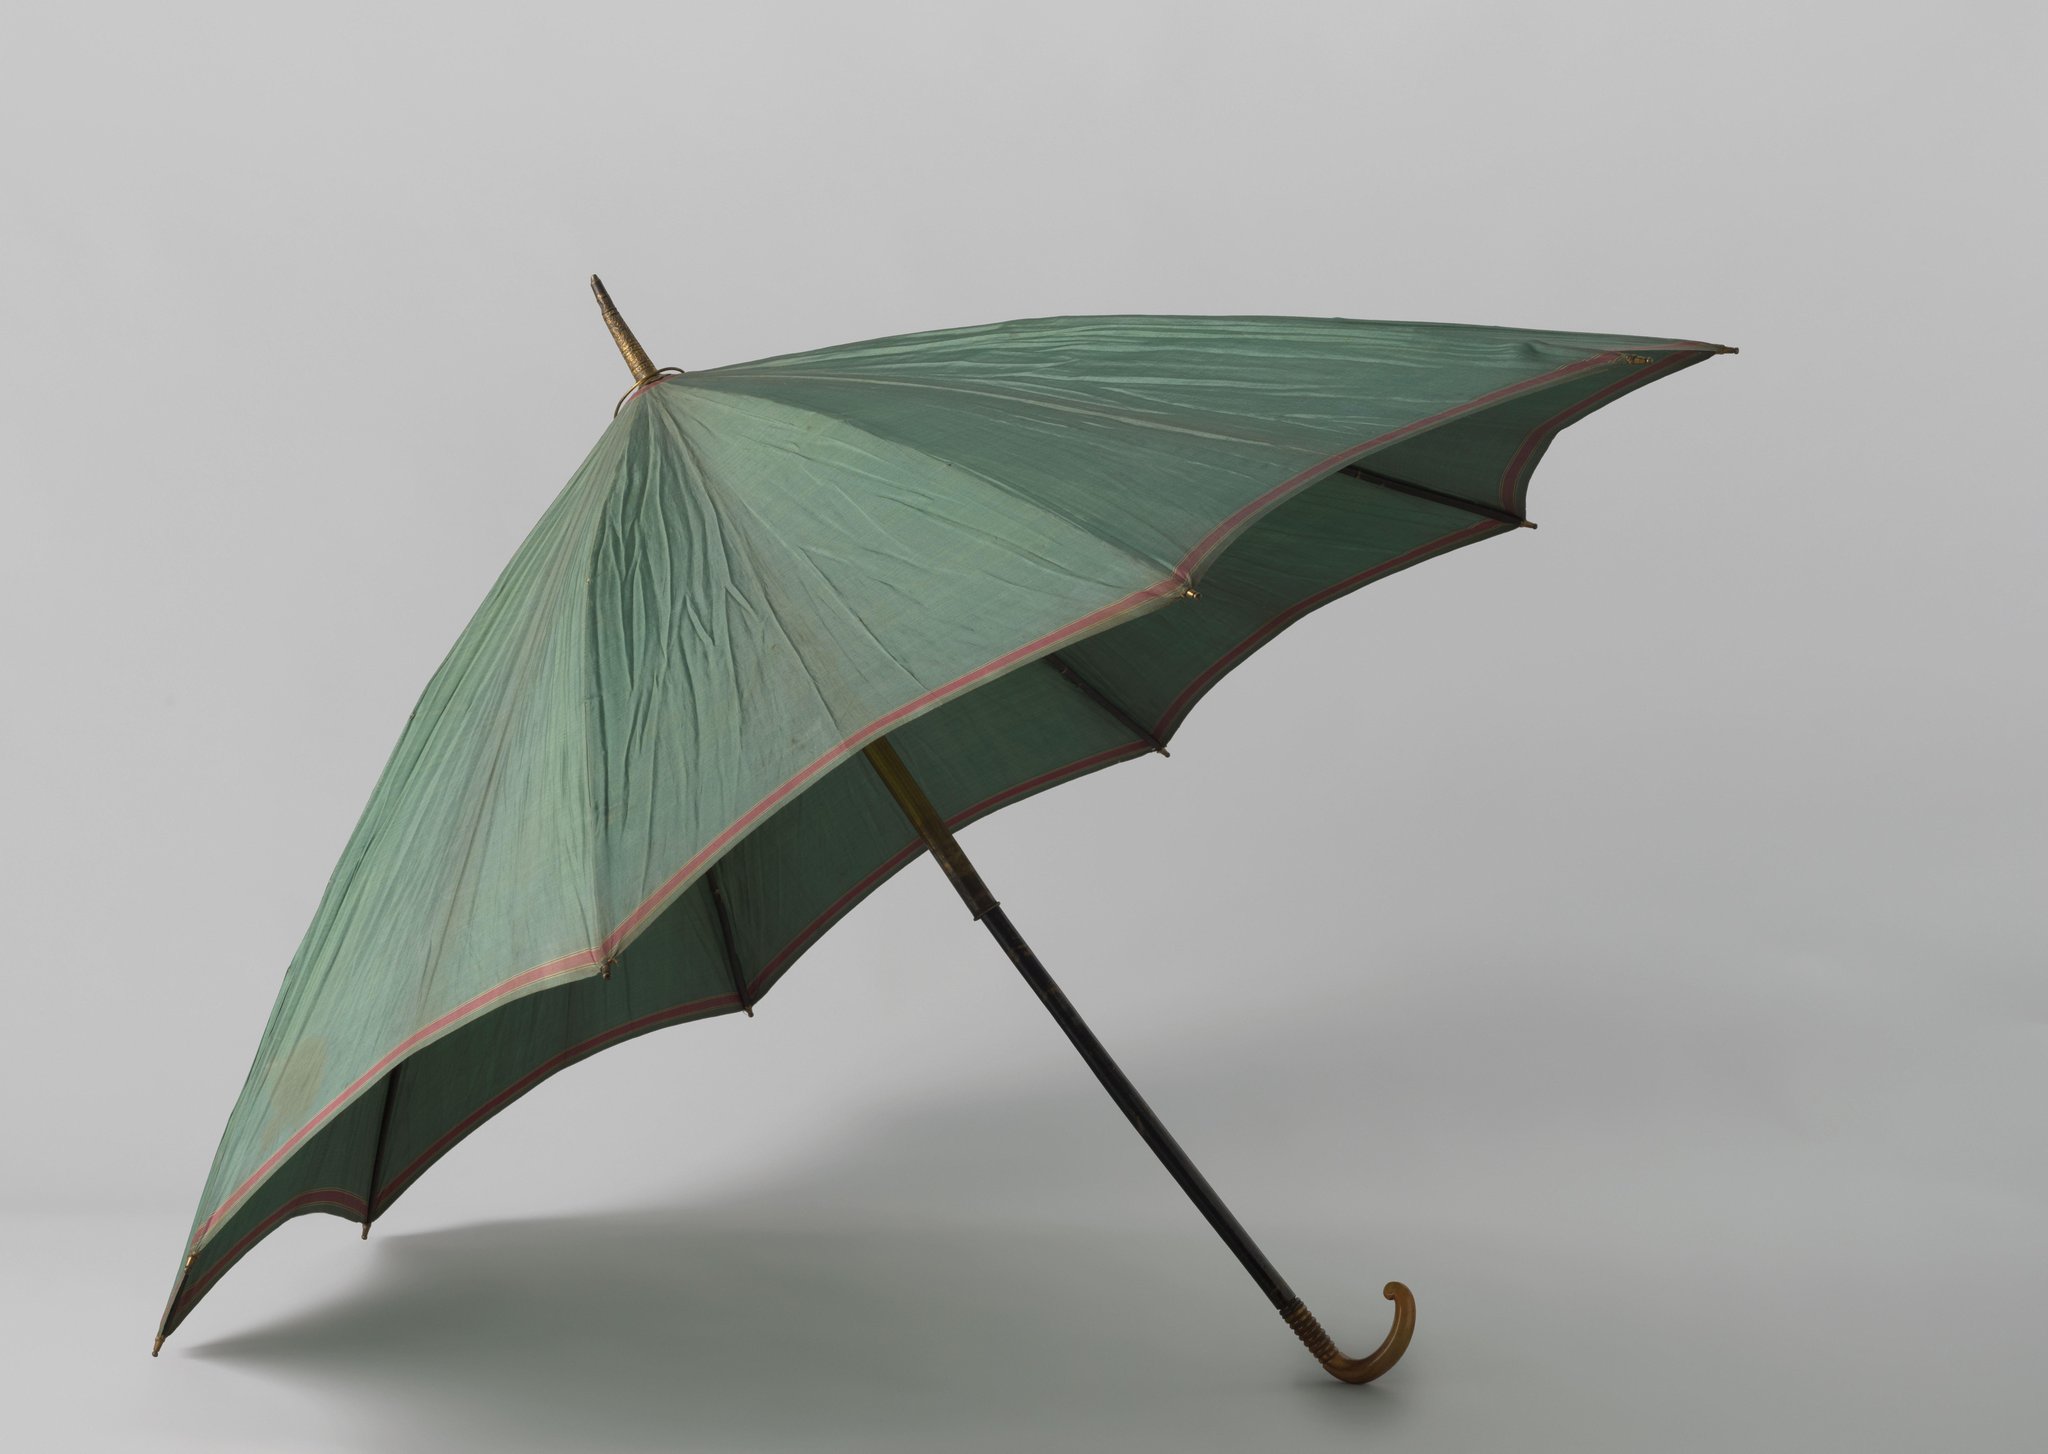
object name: parasol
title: Paraplu en tevens parasol met dek van effen blauwgroene zijde met een rode rand, op houten stok met hoornen handvat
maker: Anonymous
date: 1825-1835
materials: baleen, copper, horn, paint, silk, wood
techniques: cutting, forging, striking, weave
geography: netherlands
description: Parapluie, besteedster d.i. een groot model parapluie uit het begin de 19e eeuw van blauw, groen zijde met rooden rand. Punt in verder garnutuur van koper de punt met ingeslagen figuren hoornen knop. In bruin linnen foudraal. De baleinen zijn, van echt walvisbalein, vierkant in doorsnede wordt gesloten gehouden door een koperen ring, die aan een koortje midden op de zijden bekleding is genaaid.